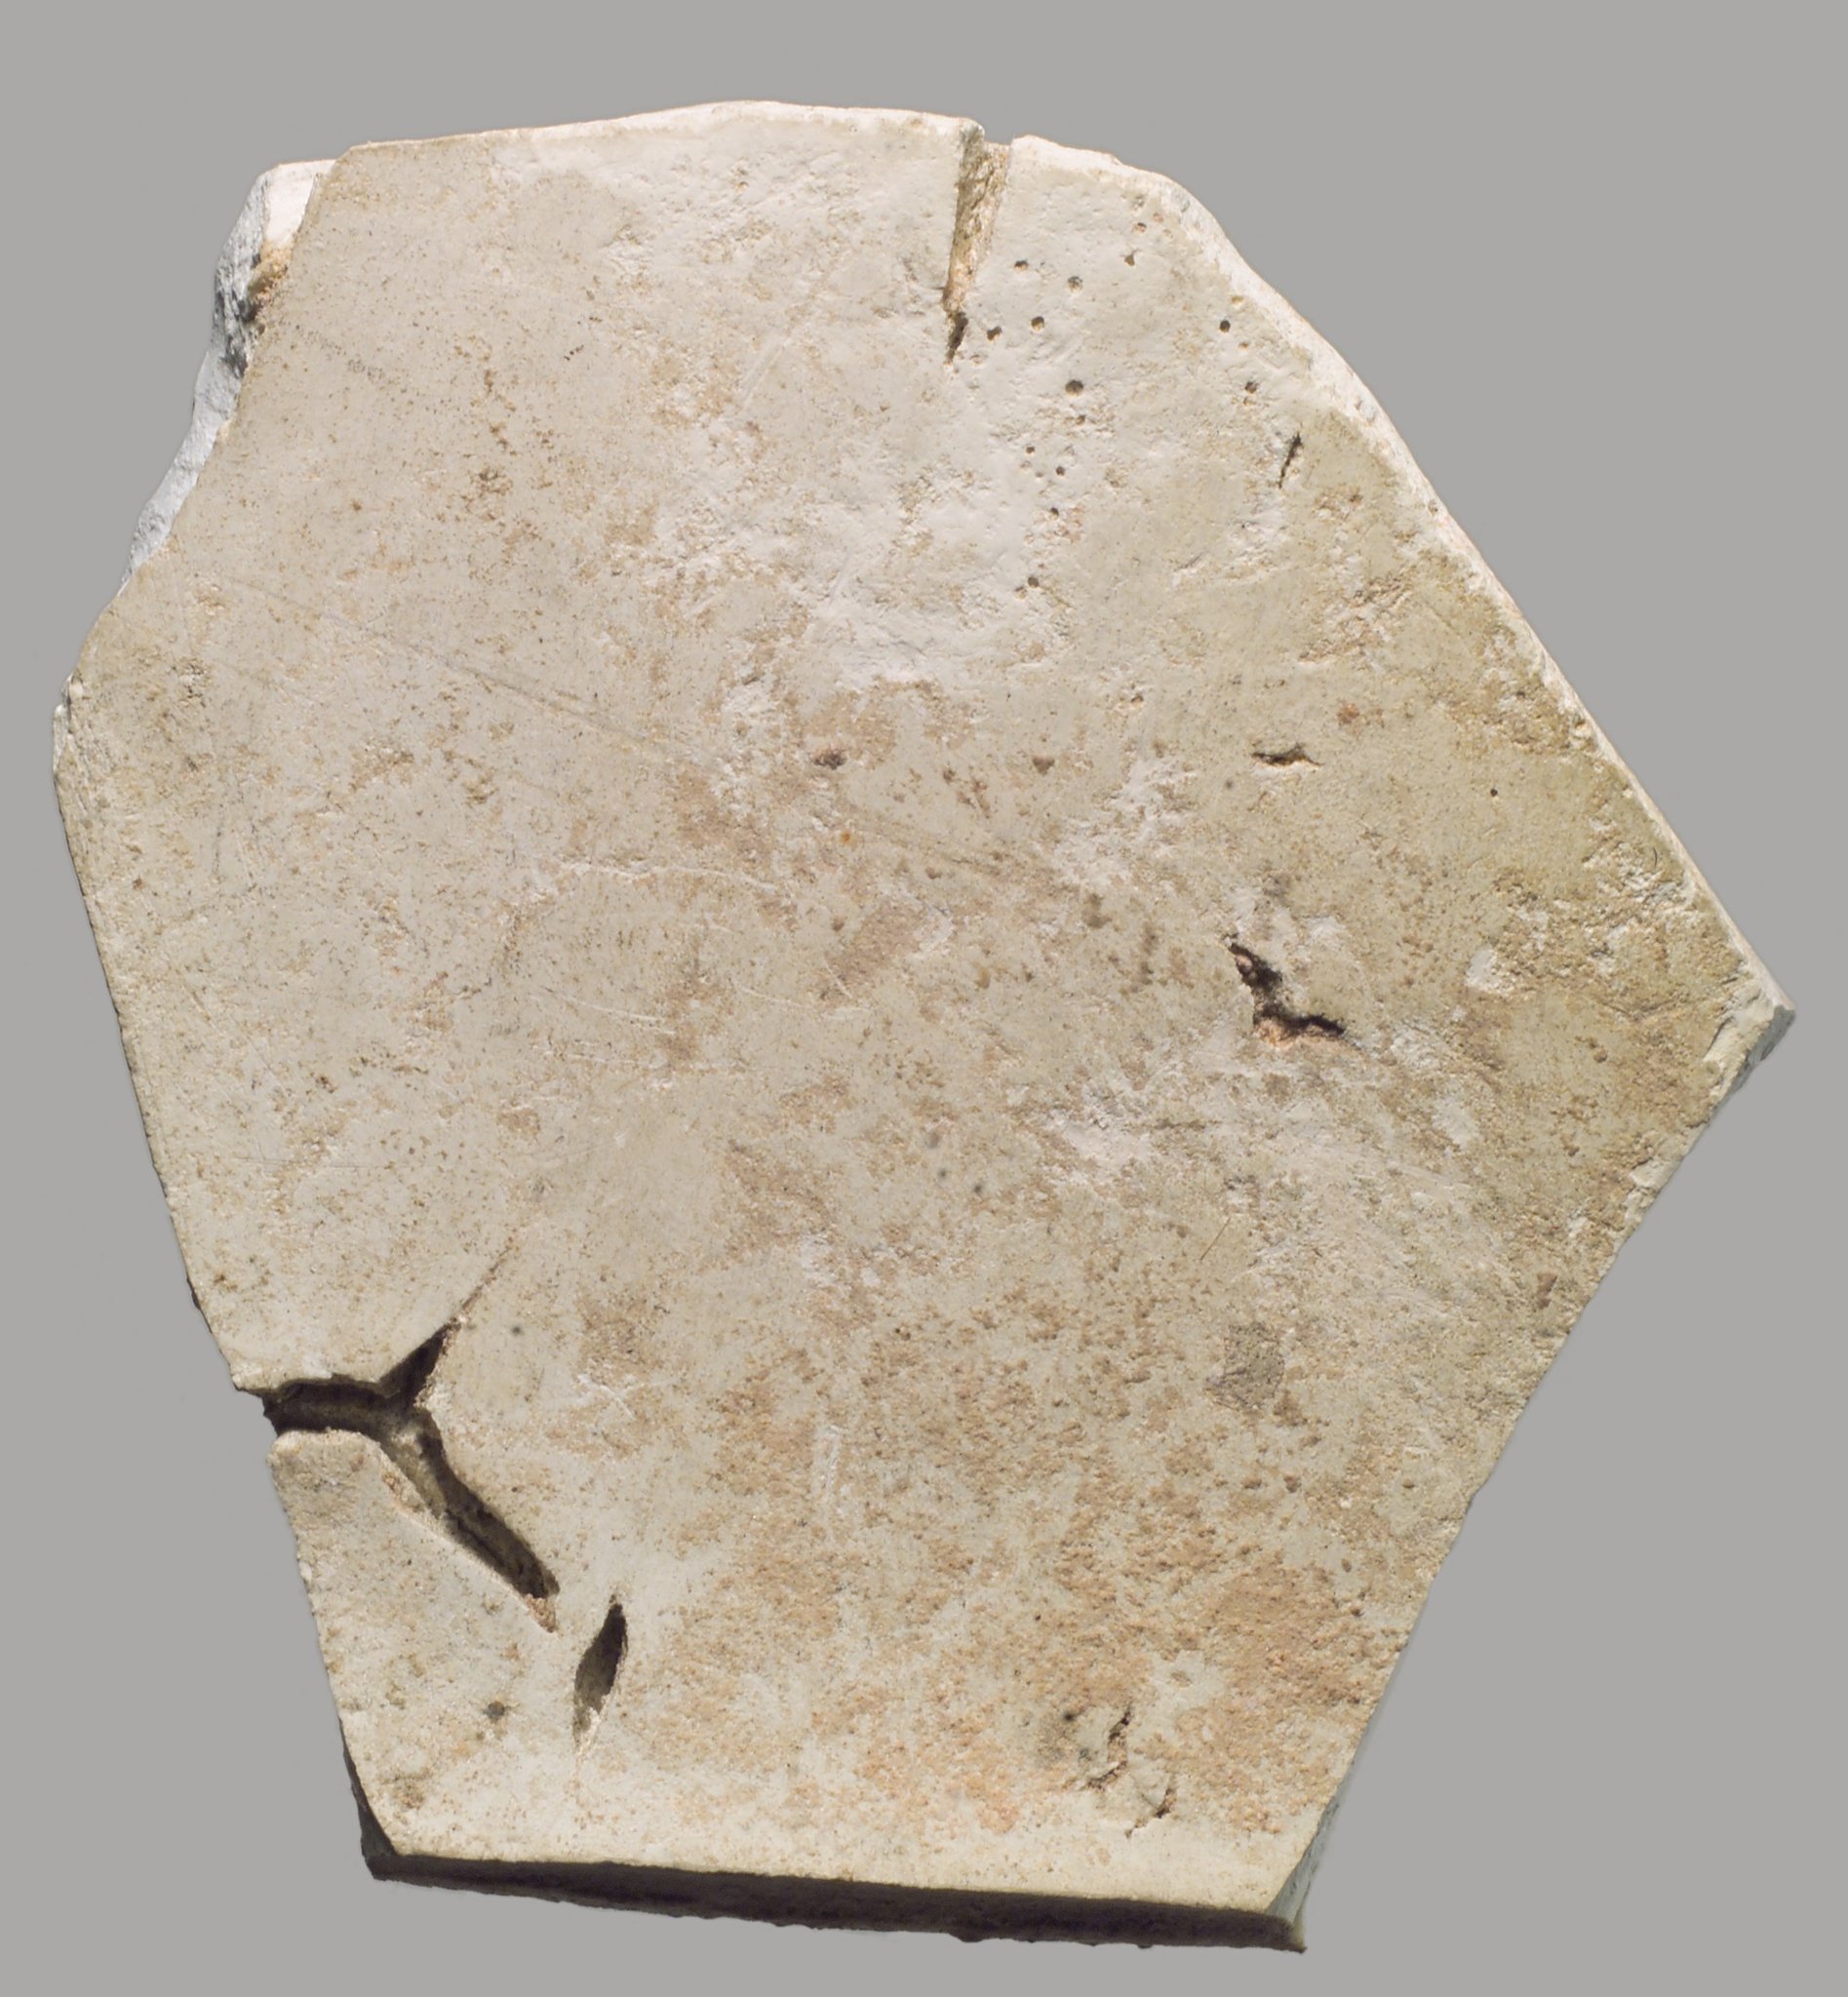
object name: furniture element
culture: assyrian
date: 1800-1701 BCE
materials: ivory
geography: anatolia